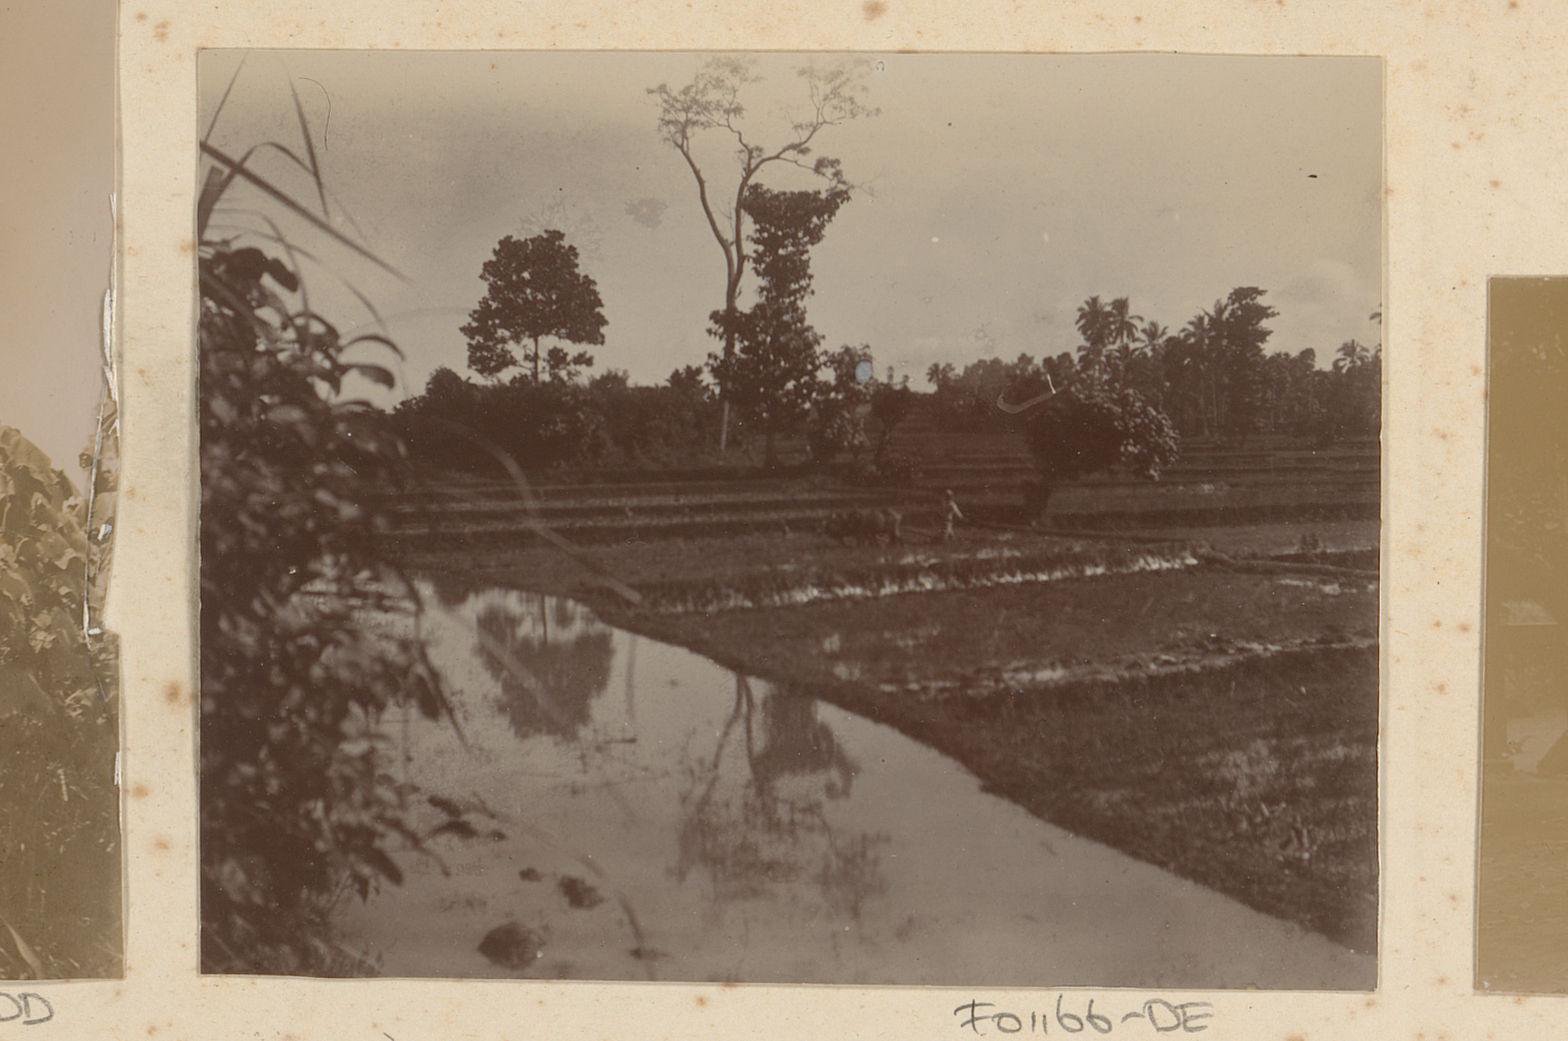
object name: photograph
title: Landbouwgrond naast water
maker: Anonymous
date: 1895-1910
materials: photographic support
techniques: gelatin silver print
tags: cultivated land (in tropical and sub-tropical regions), landscapes with waters, waterscapes, seascapes (in the temperate zone)